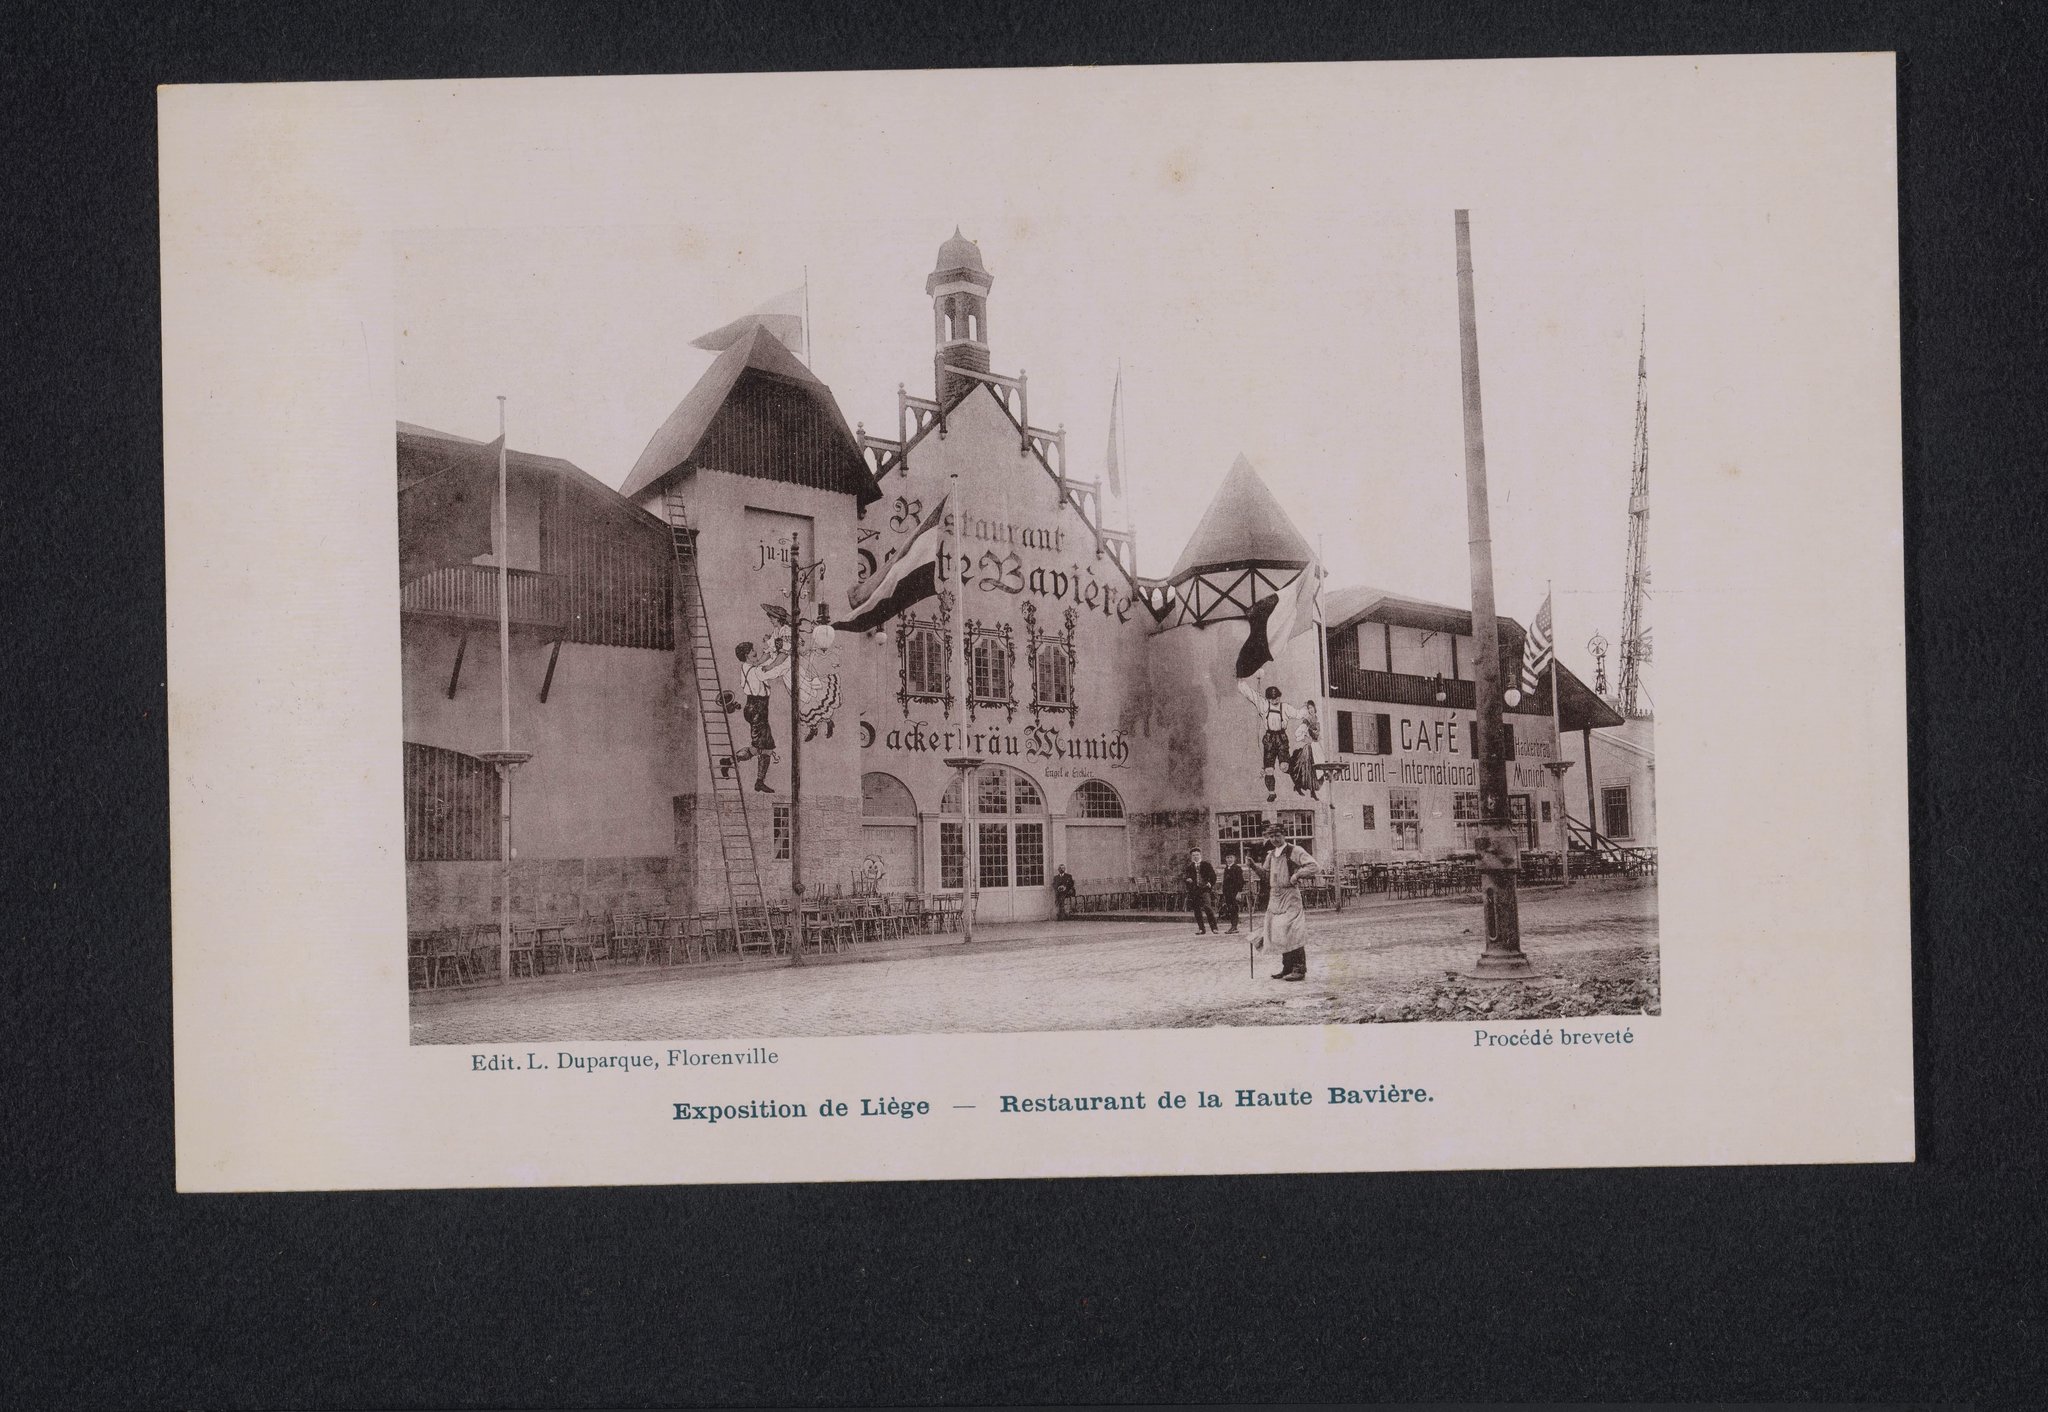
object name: photomechanical print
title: Exposition de Liège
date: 1905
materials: paper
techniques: photograph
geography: florenville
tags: world fair, world exhibition, restaurant, liège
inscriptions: inscription: ‘Procédé breveté’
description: Deze prent maakt deel uit van een omslag met 16 prenten.